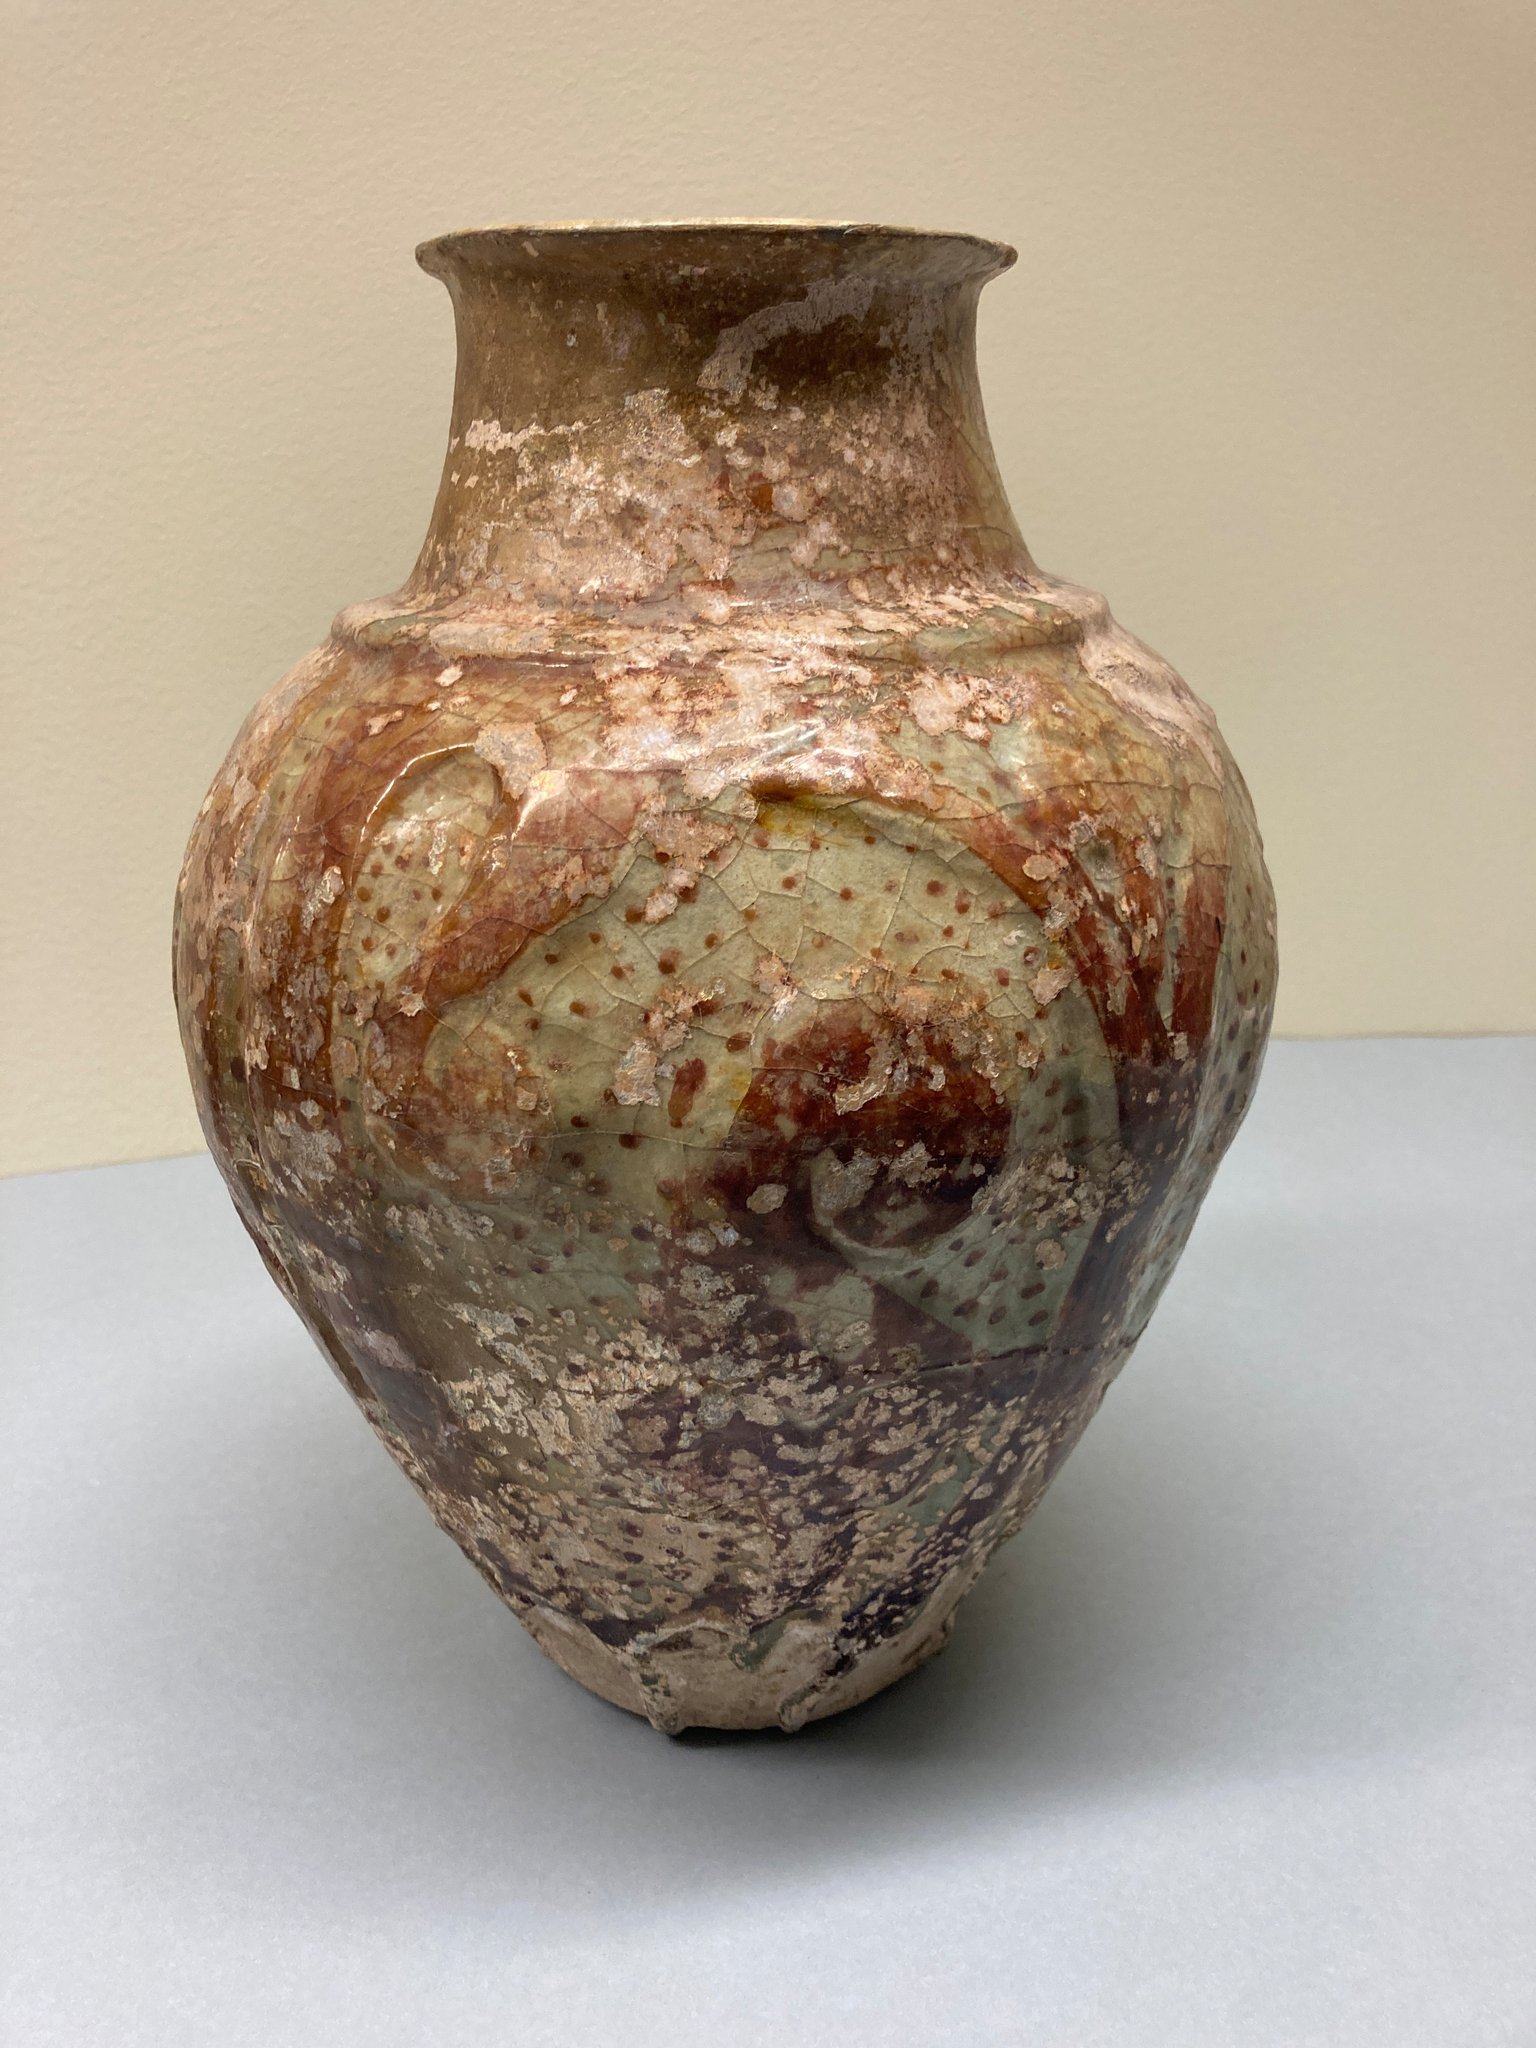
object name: jar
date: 1101-1300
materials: stonepaste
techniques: luster painting, underglaze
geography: syria